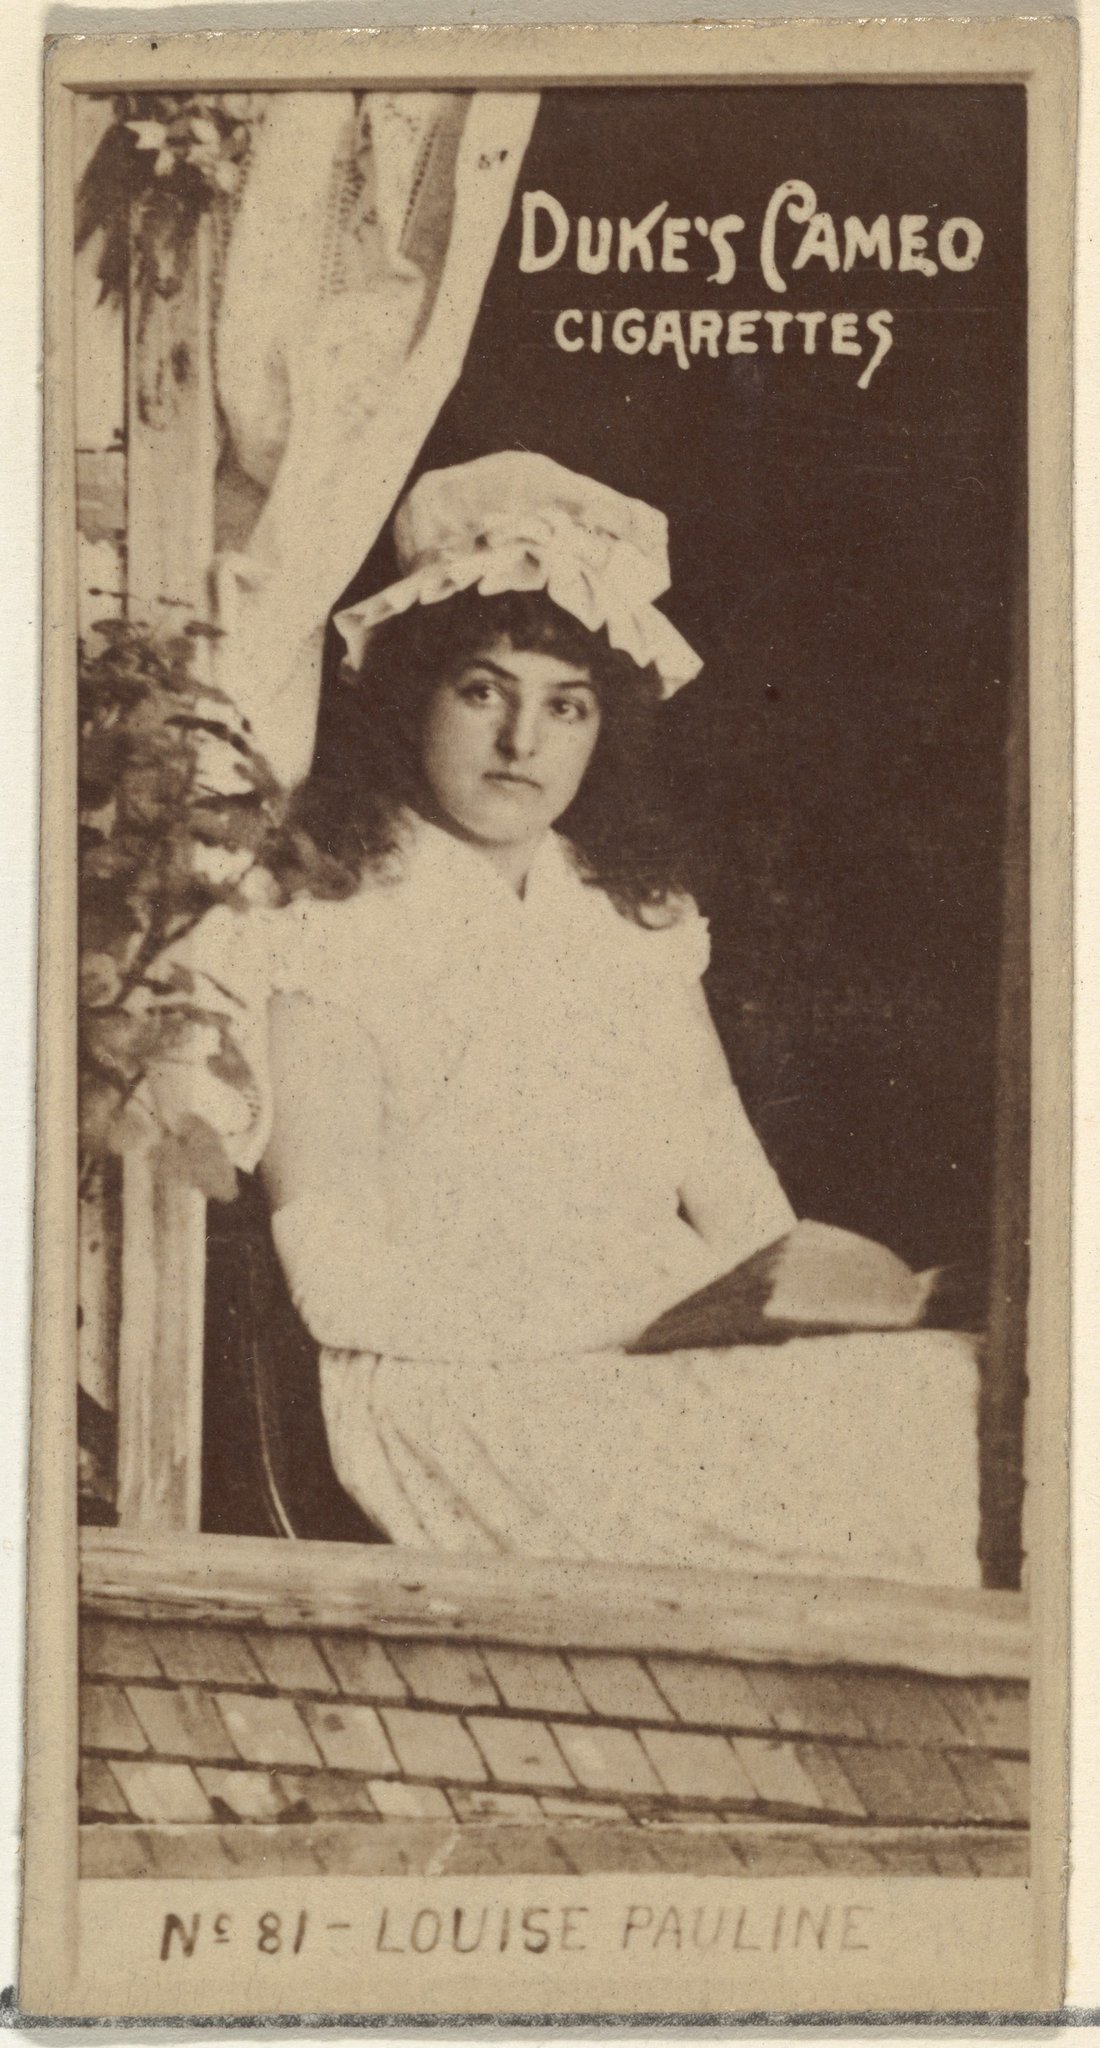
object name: photograph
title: Card Number 81, Louise Pauline, from the Actors and Actresses series (N145-4) issued by Duke Sons & Co. to promote Cameo Cigarettes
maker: w. duke, sons & co.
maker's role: publisher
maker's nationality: american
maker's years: 1870-1920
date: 1880-1889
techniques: albumen silver print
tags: portraits,women,actresses